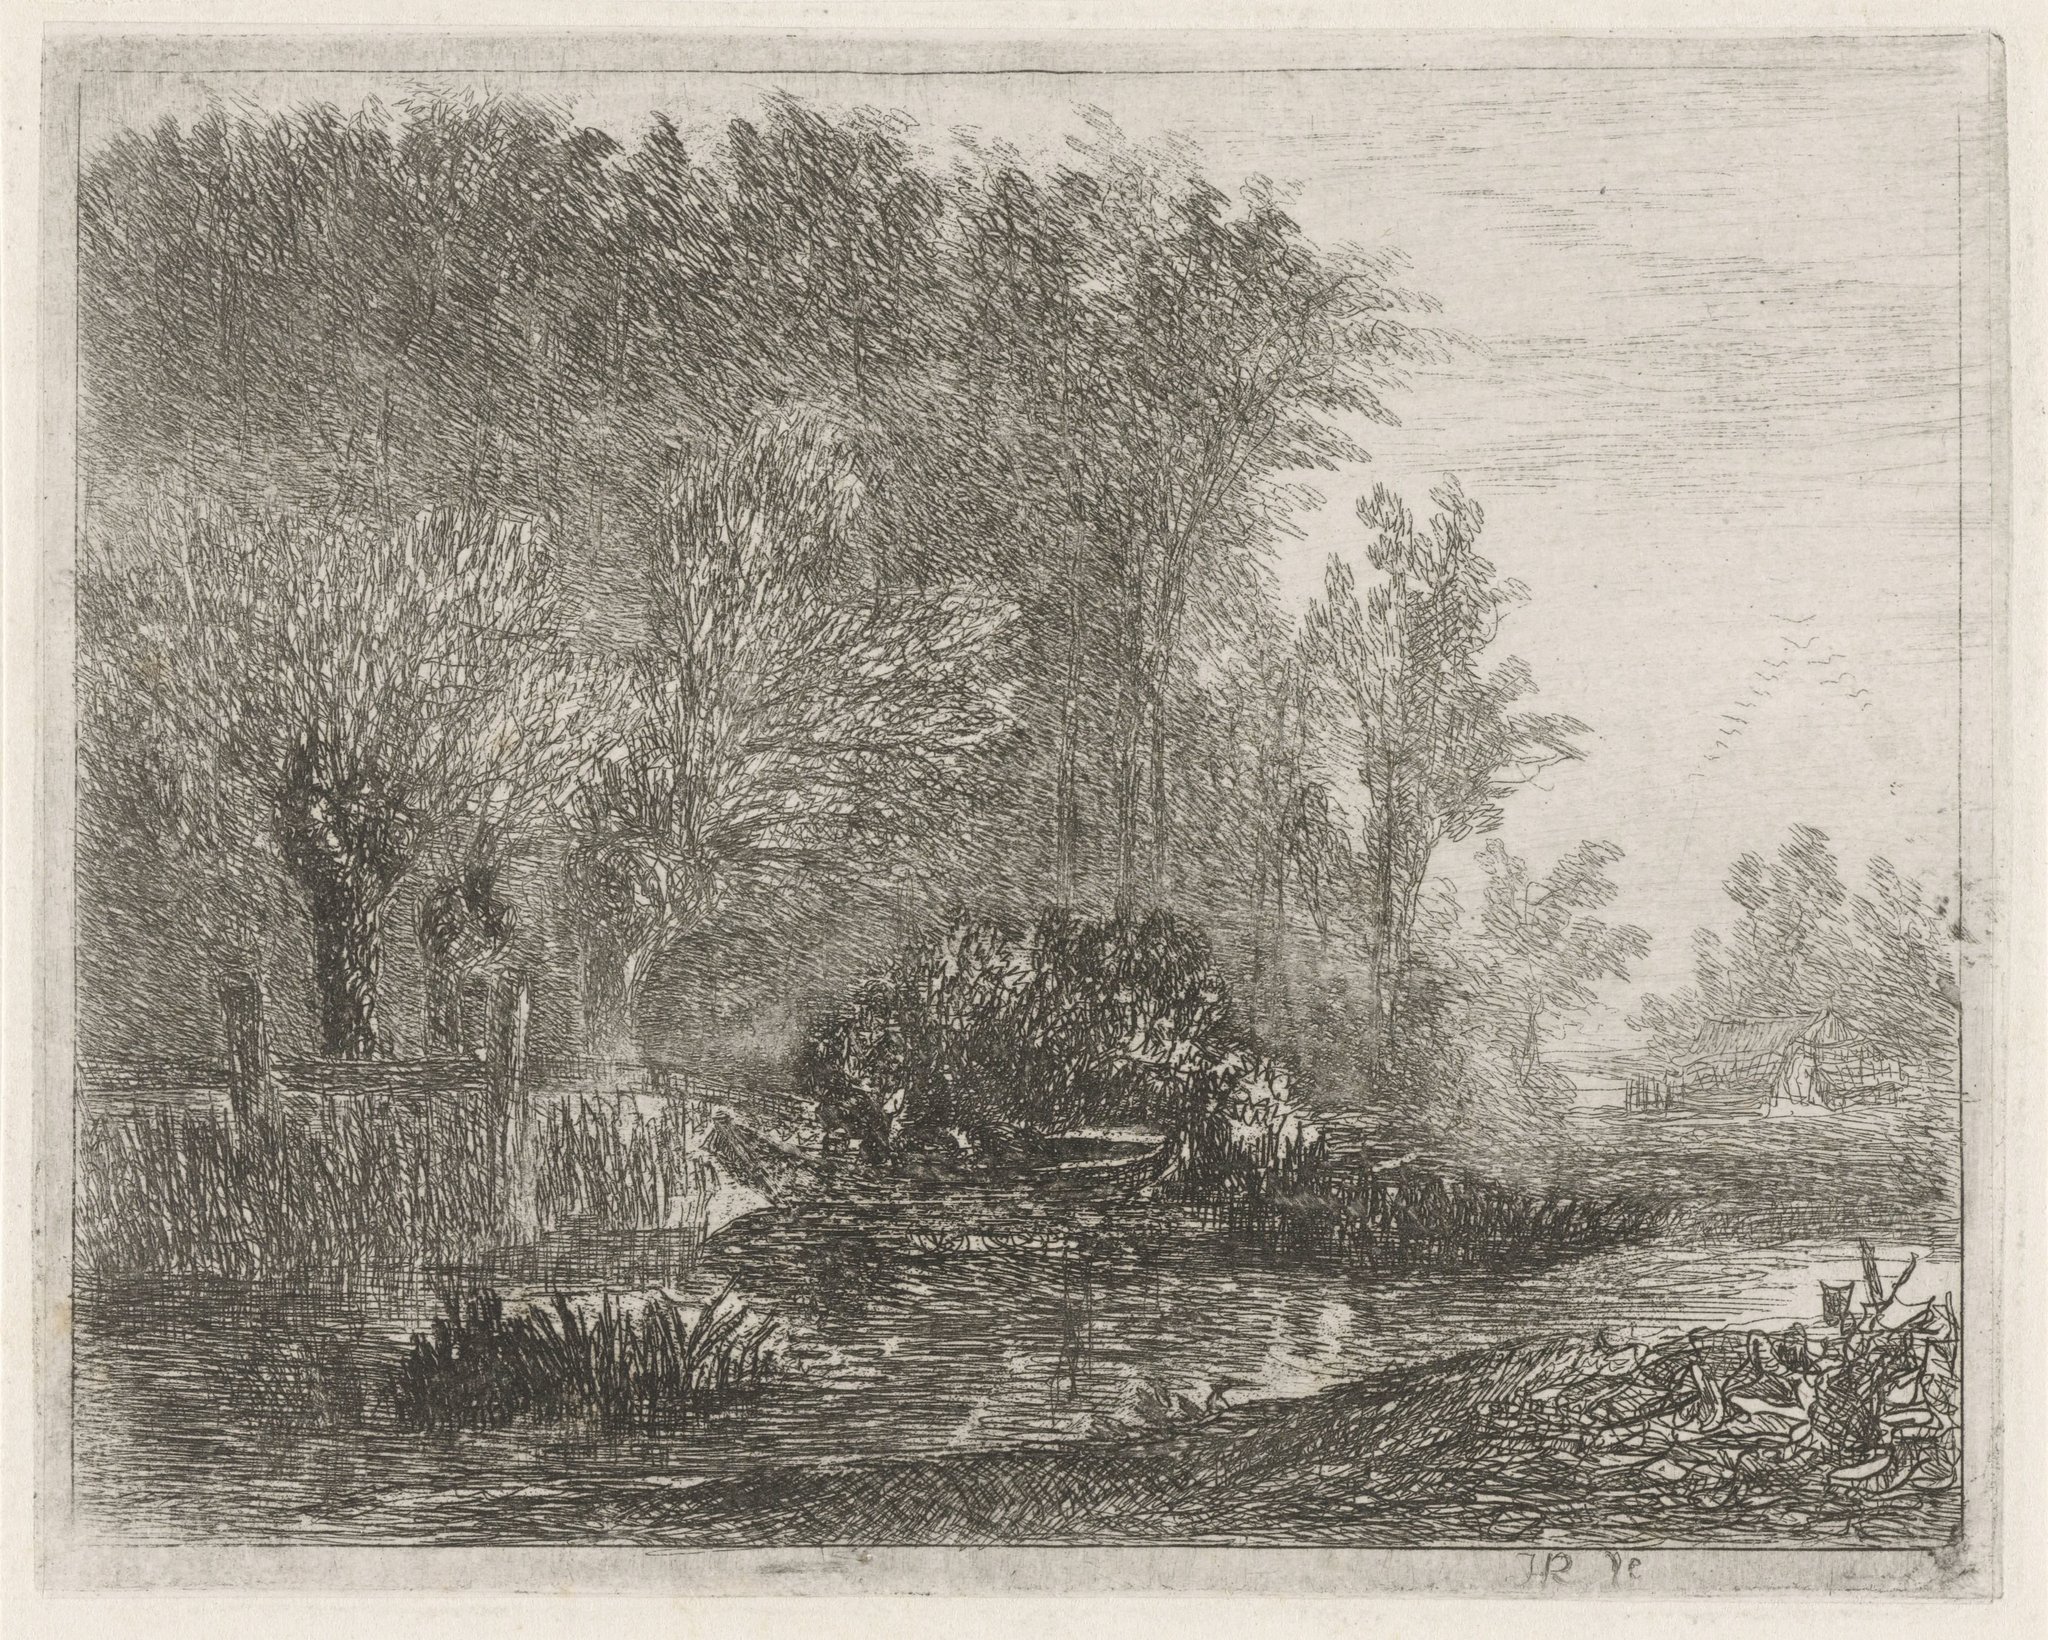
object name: print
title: Visser in een boot aan de bosrand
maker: hermanus jan hendrik van rijkelijkhuysen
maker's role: painter, print maker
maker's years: 1813-1883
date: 1823-1883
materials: paper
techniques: drypoint, etching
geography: utrecht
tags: river, forest, wood, hut, cabin, lodge, fisherman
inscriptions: collector's mark: Lugt 1485, collector's mark: Lugt 2228